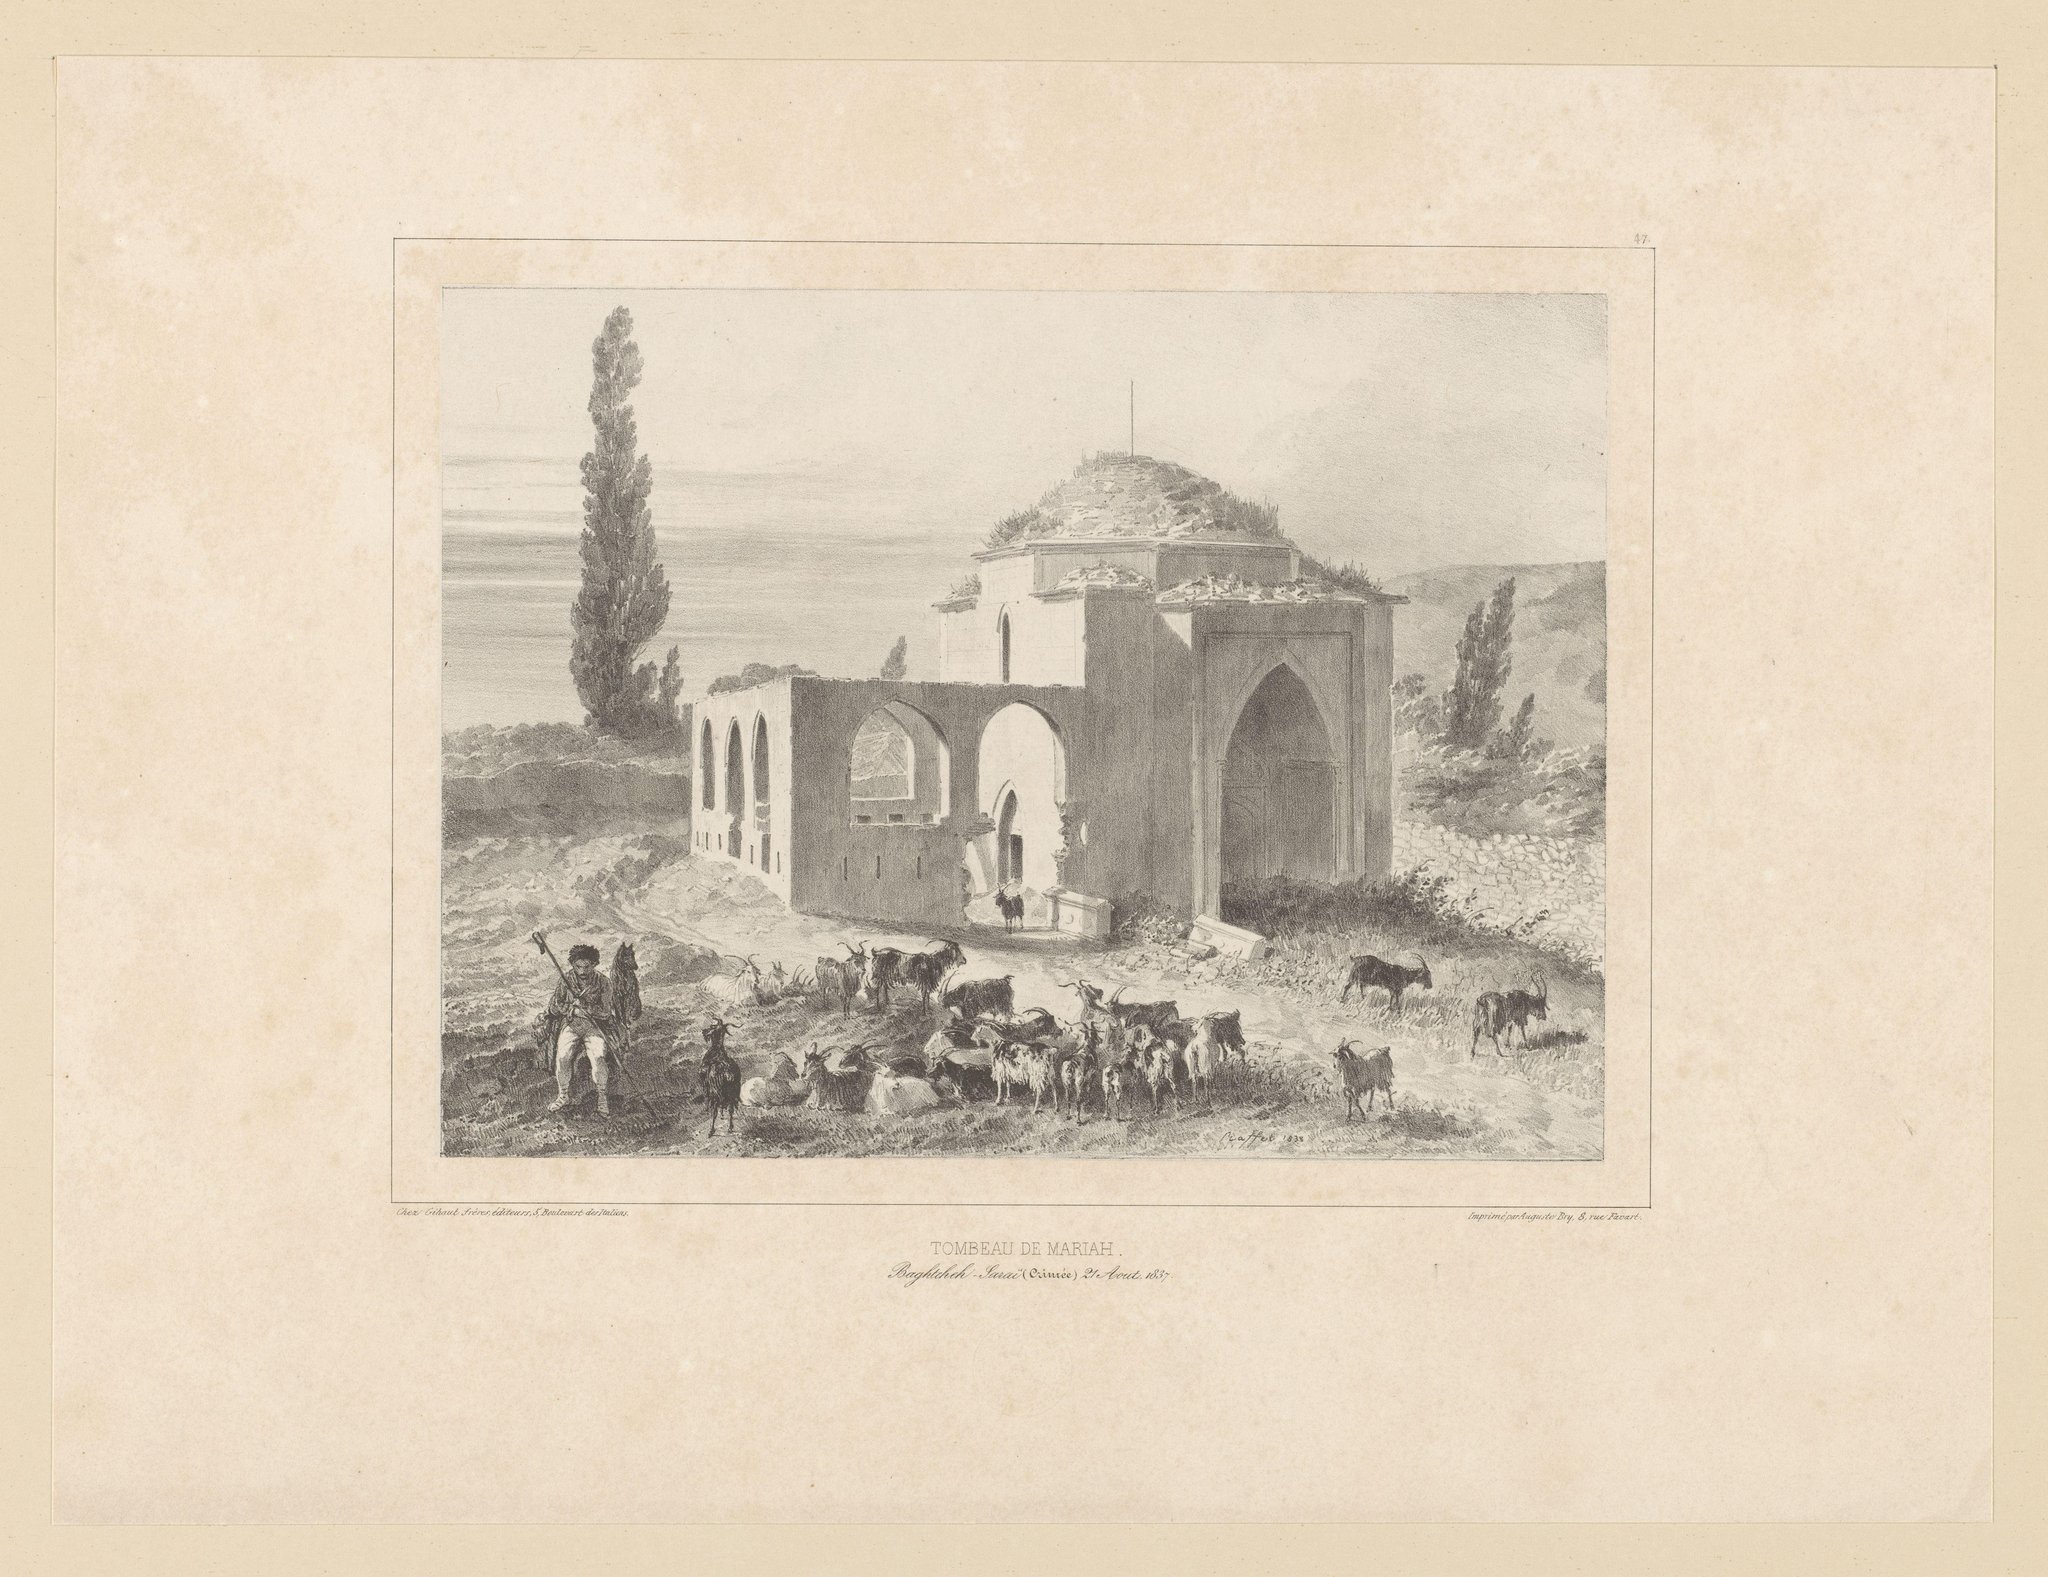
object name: print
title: Reis door Zuid-Rusland en de Krim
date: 1838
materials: paper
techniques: lithograph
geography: paris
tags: herding, herdsman, herdswoman, shepherd, shepherdess, cowherd, etc., grave-building, monumental tomb, goat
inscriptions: check stamp: ‘Ernest Bourdin éditeur Paris.R. de Seine.51’, collector's mark: Lugt 2760, collector's mark: Lugt 2228